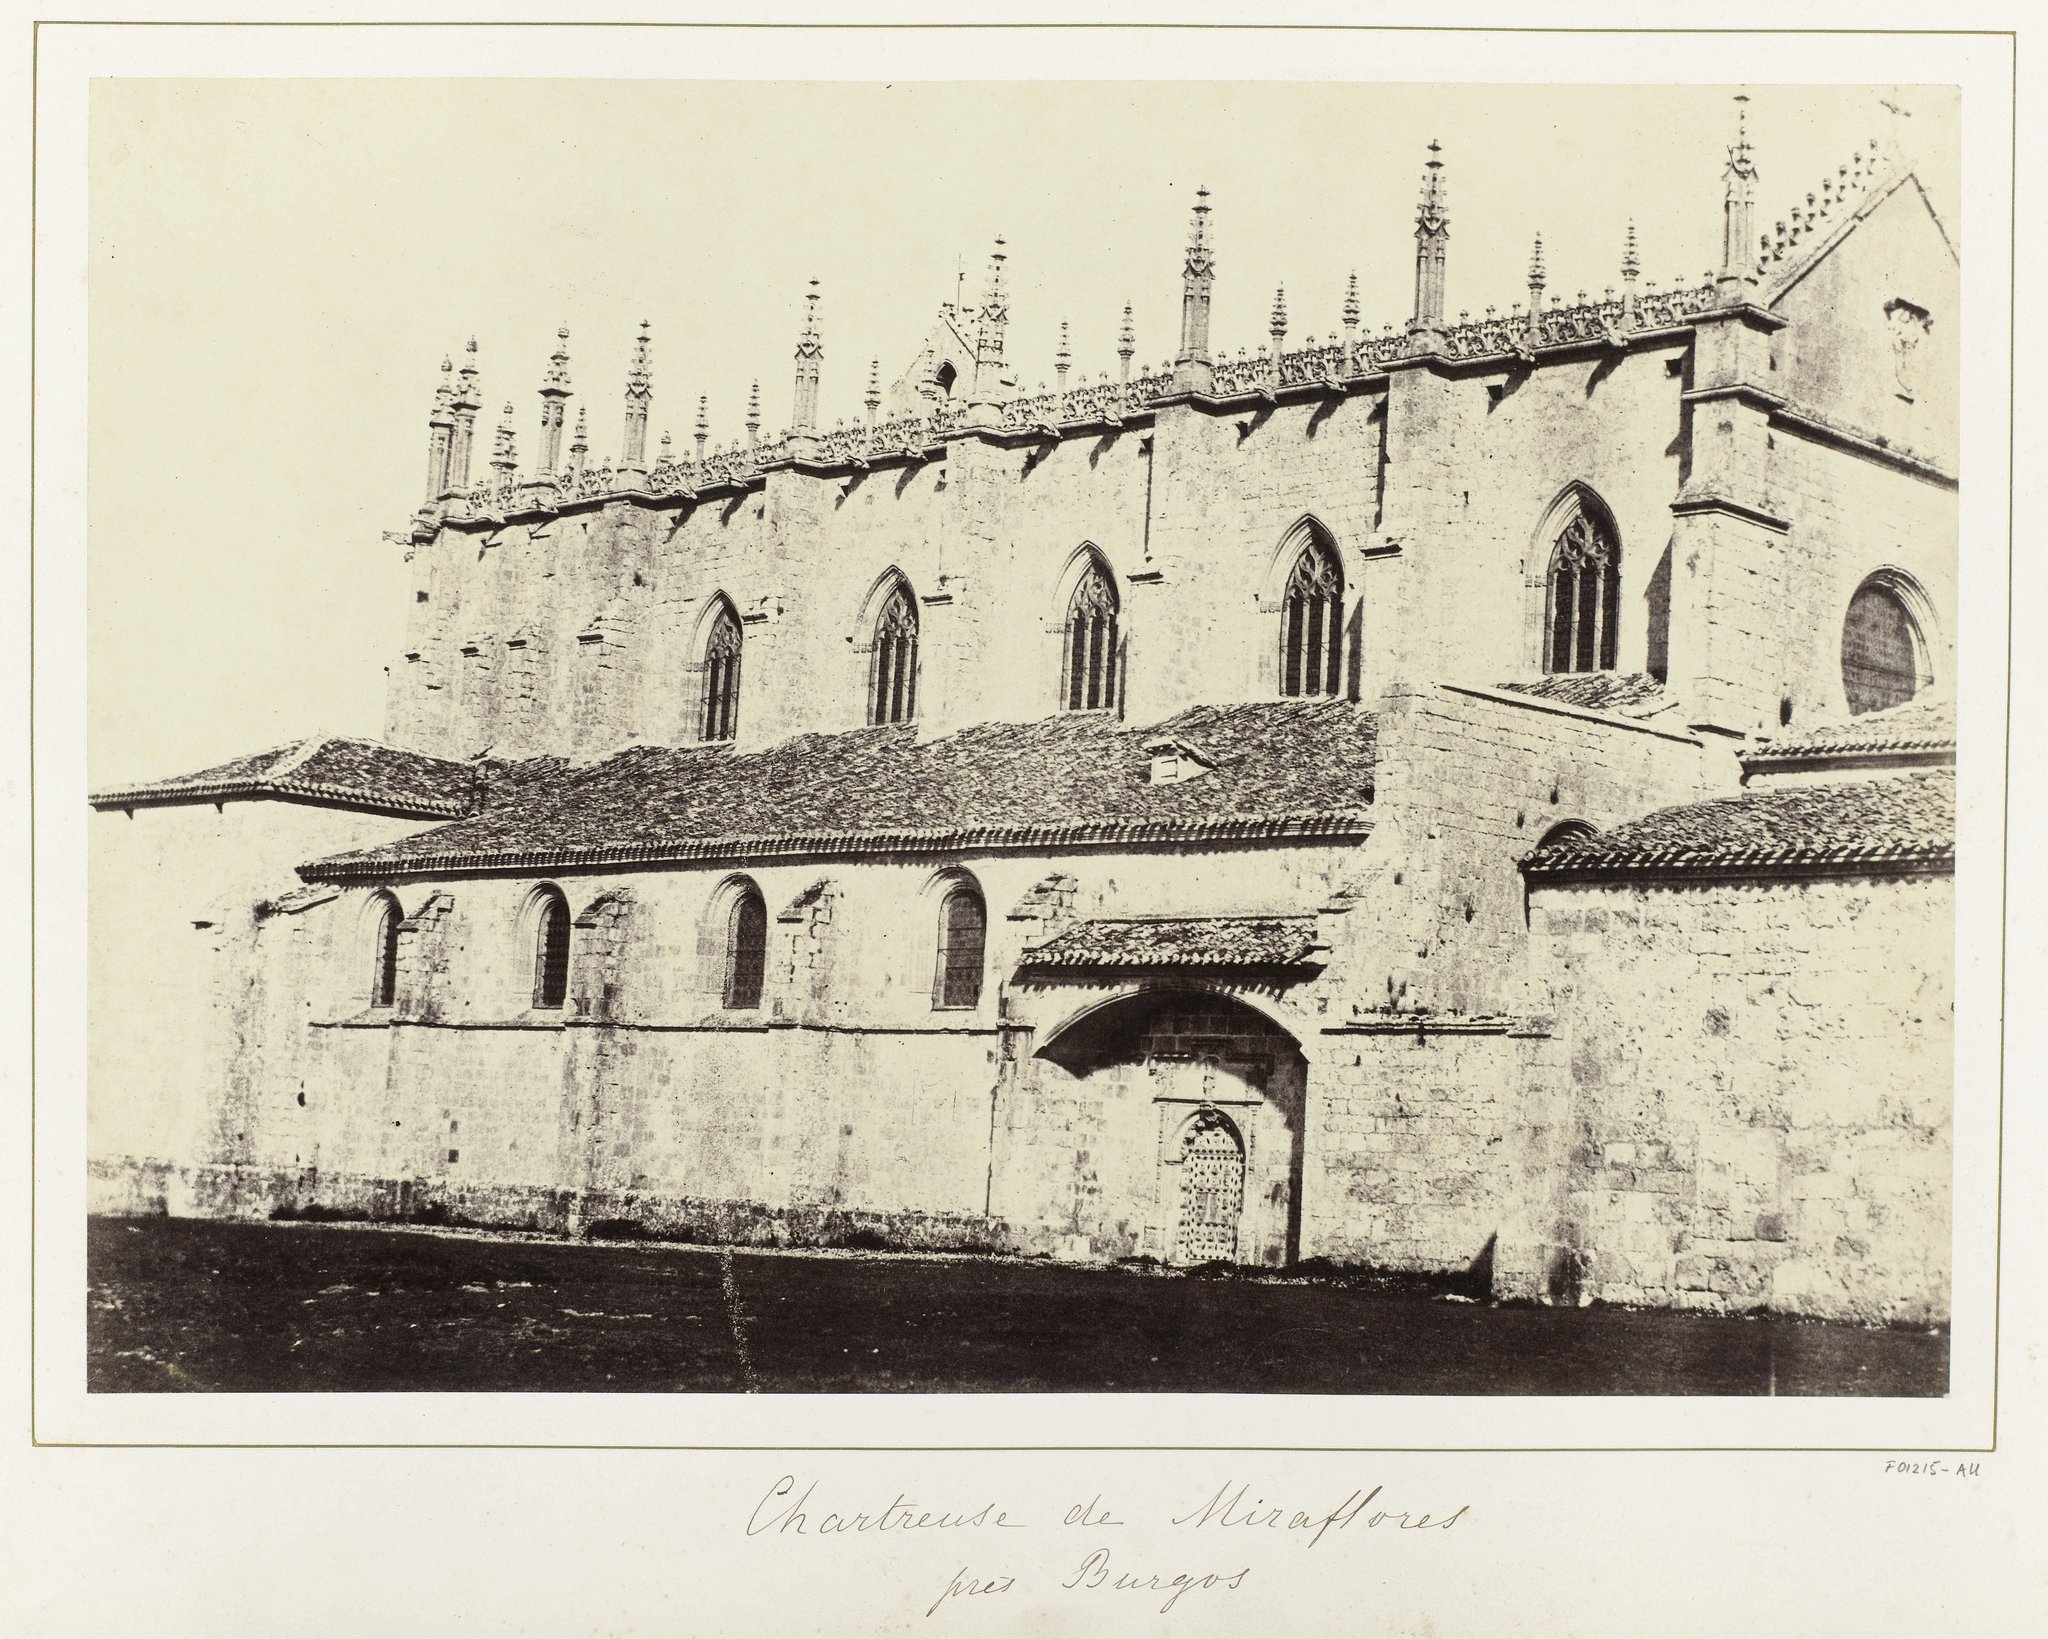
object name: photograph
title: Exterieur van het kartuizerklooster van Miraflores bij Burgos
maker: charles clifford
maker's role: fotograaf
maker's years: 1819-1863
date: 1850-1863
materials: photographic support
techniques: albumen print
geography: burgos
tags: burgos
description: Onderdeel van Reisalbum met opnames van kunstwerken, personen en bezienswaardigheden in Spanje.